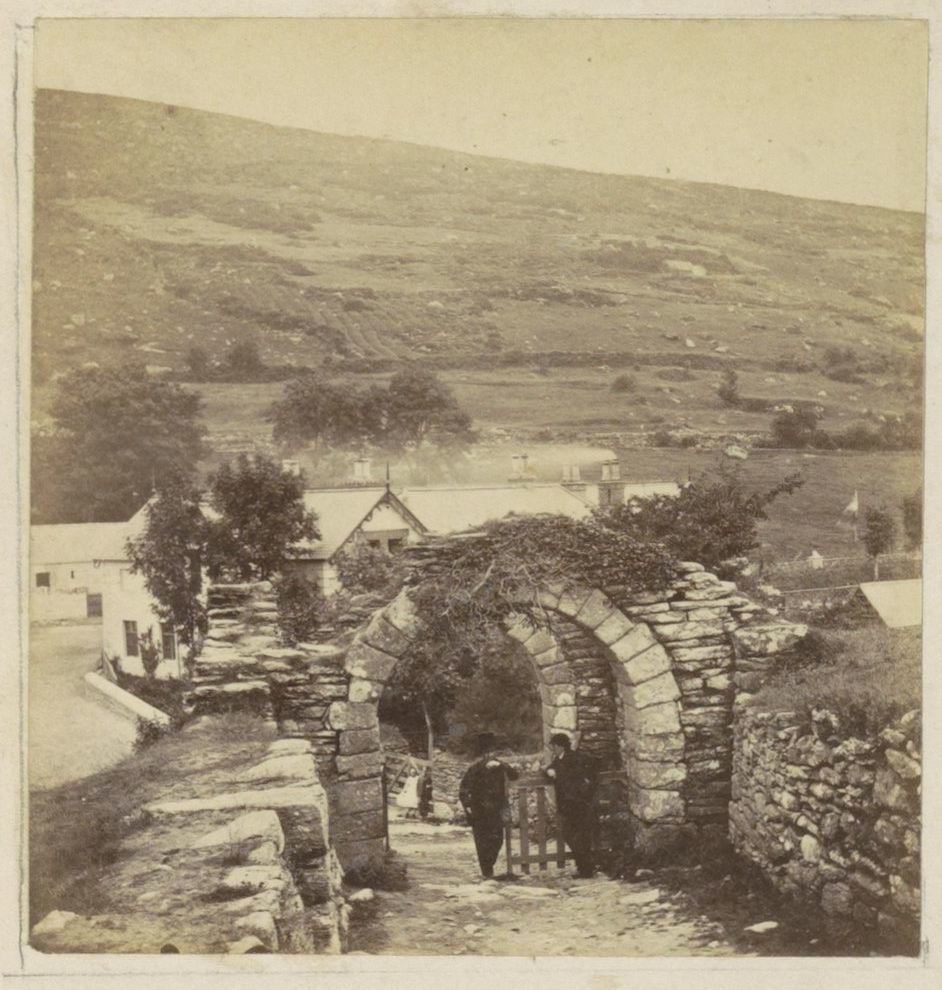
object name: photograph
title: Landschap met een weg door een ruïne in een Engels dorp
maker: Anonymous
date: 1850-1870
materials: paper, photographic support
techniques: albumen print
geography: england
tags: village street, mountains (+ landscape with figures, staffage), ruin of a dwelling, house, castle, etc., england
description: Onderdeel van Album met foto's van bezienswaardigheden en landschappen in Engeland en van kunst.